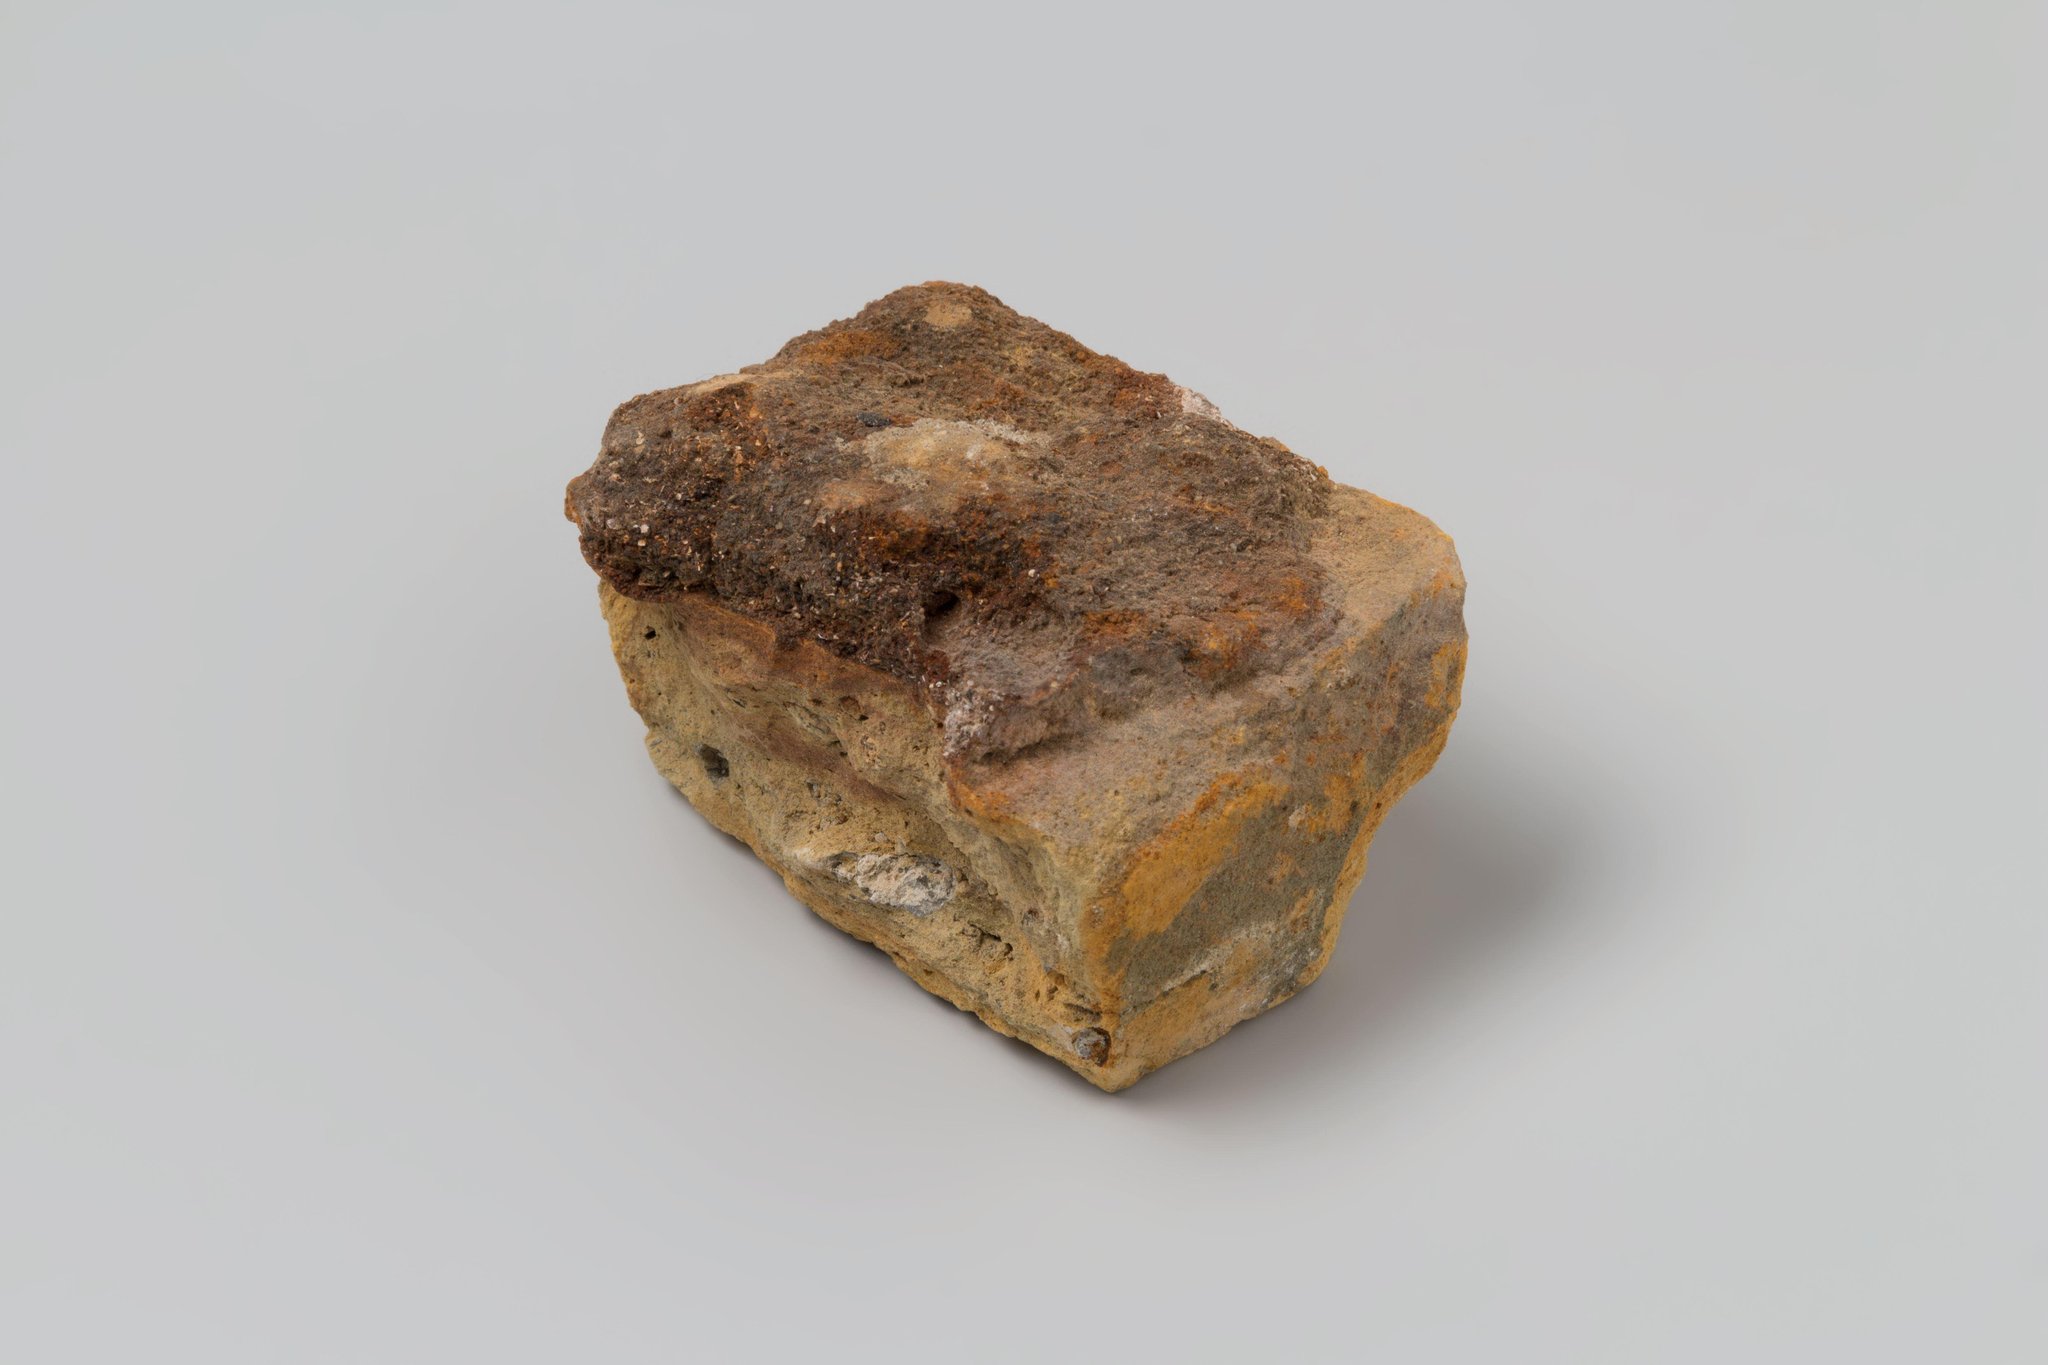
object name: brick clay product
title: Deel van een baksteen met concretie uit het wrak van de Oost-Indiëvaarder 't Vliegend Hart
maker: Anonymous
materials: brick, stone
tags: 't vliegend hart (schip), verenigde oostindische compagnie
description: Deel van een rechthoekige, geelbruine baksteen met concretie. Brick.